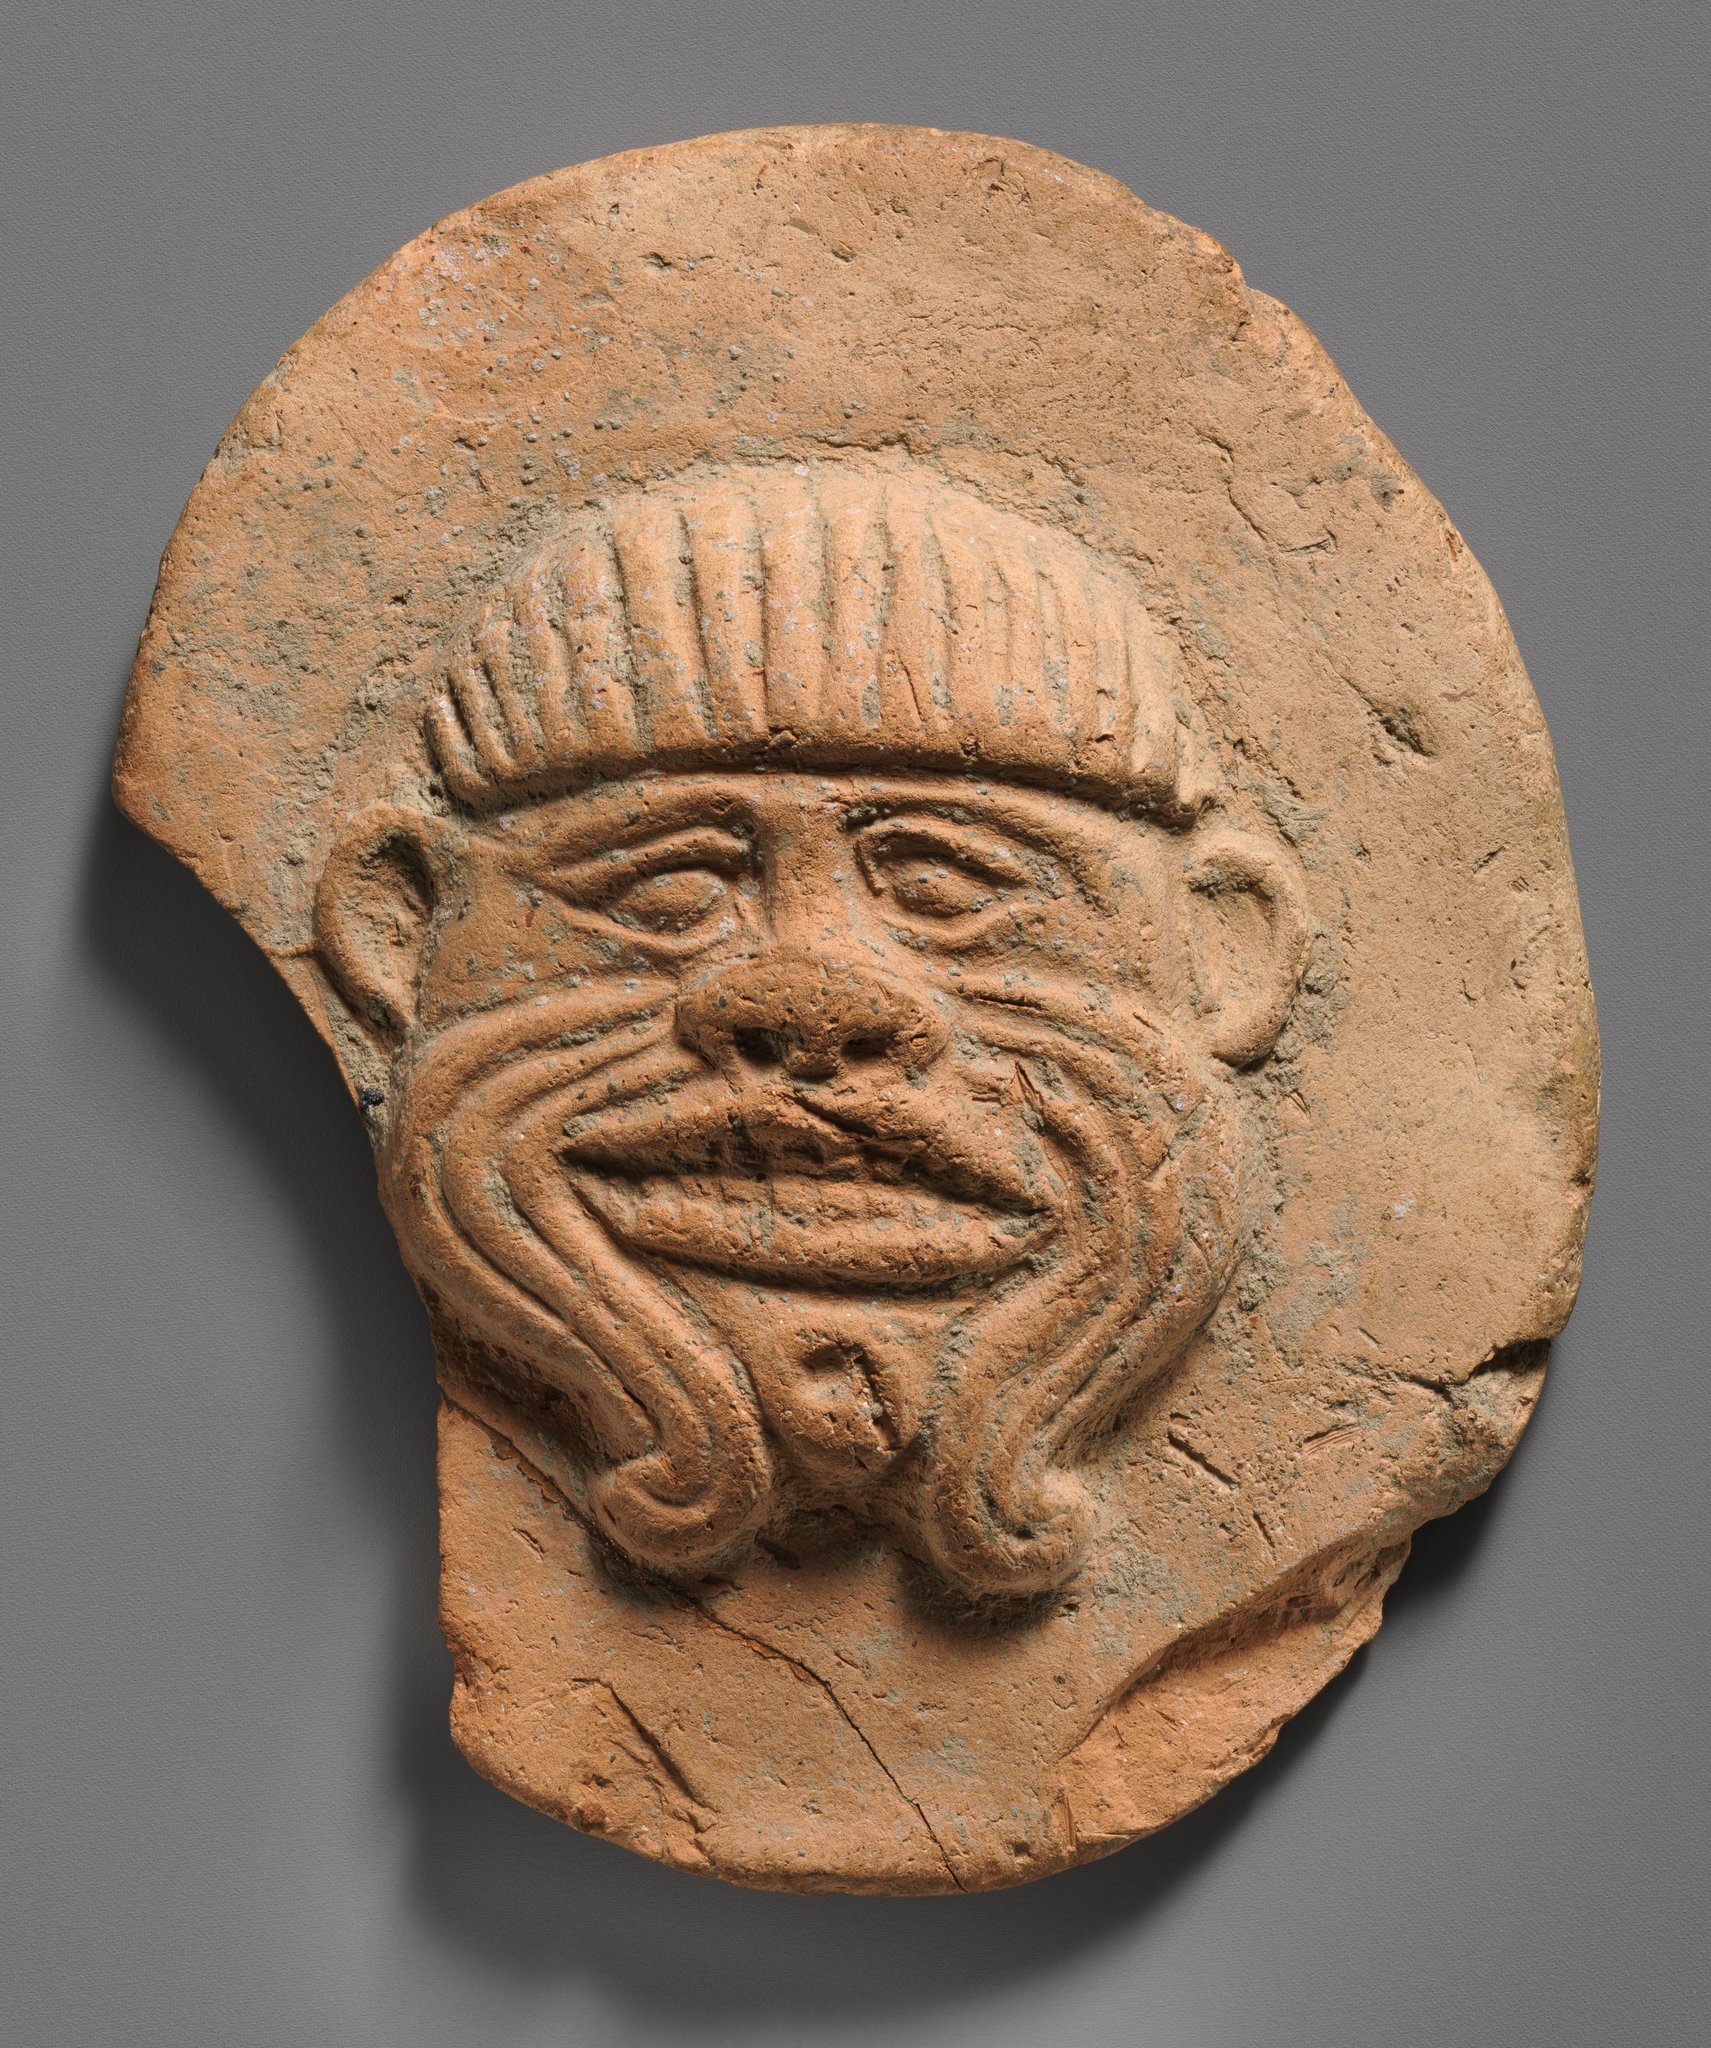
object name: relief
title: Plaque with face of the demon Humbaba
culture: babylonian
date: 2000-1600 BCE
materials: ceramic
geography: mesopotamia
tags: faces,demons